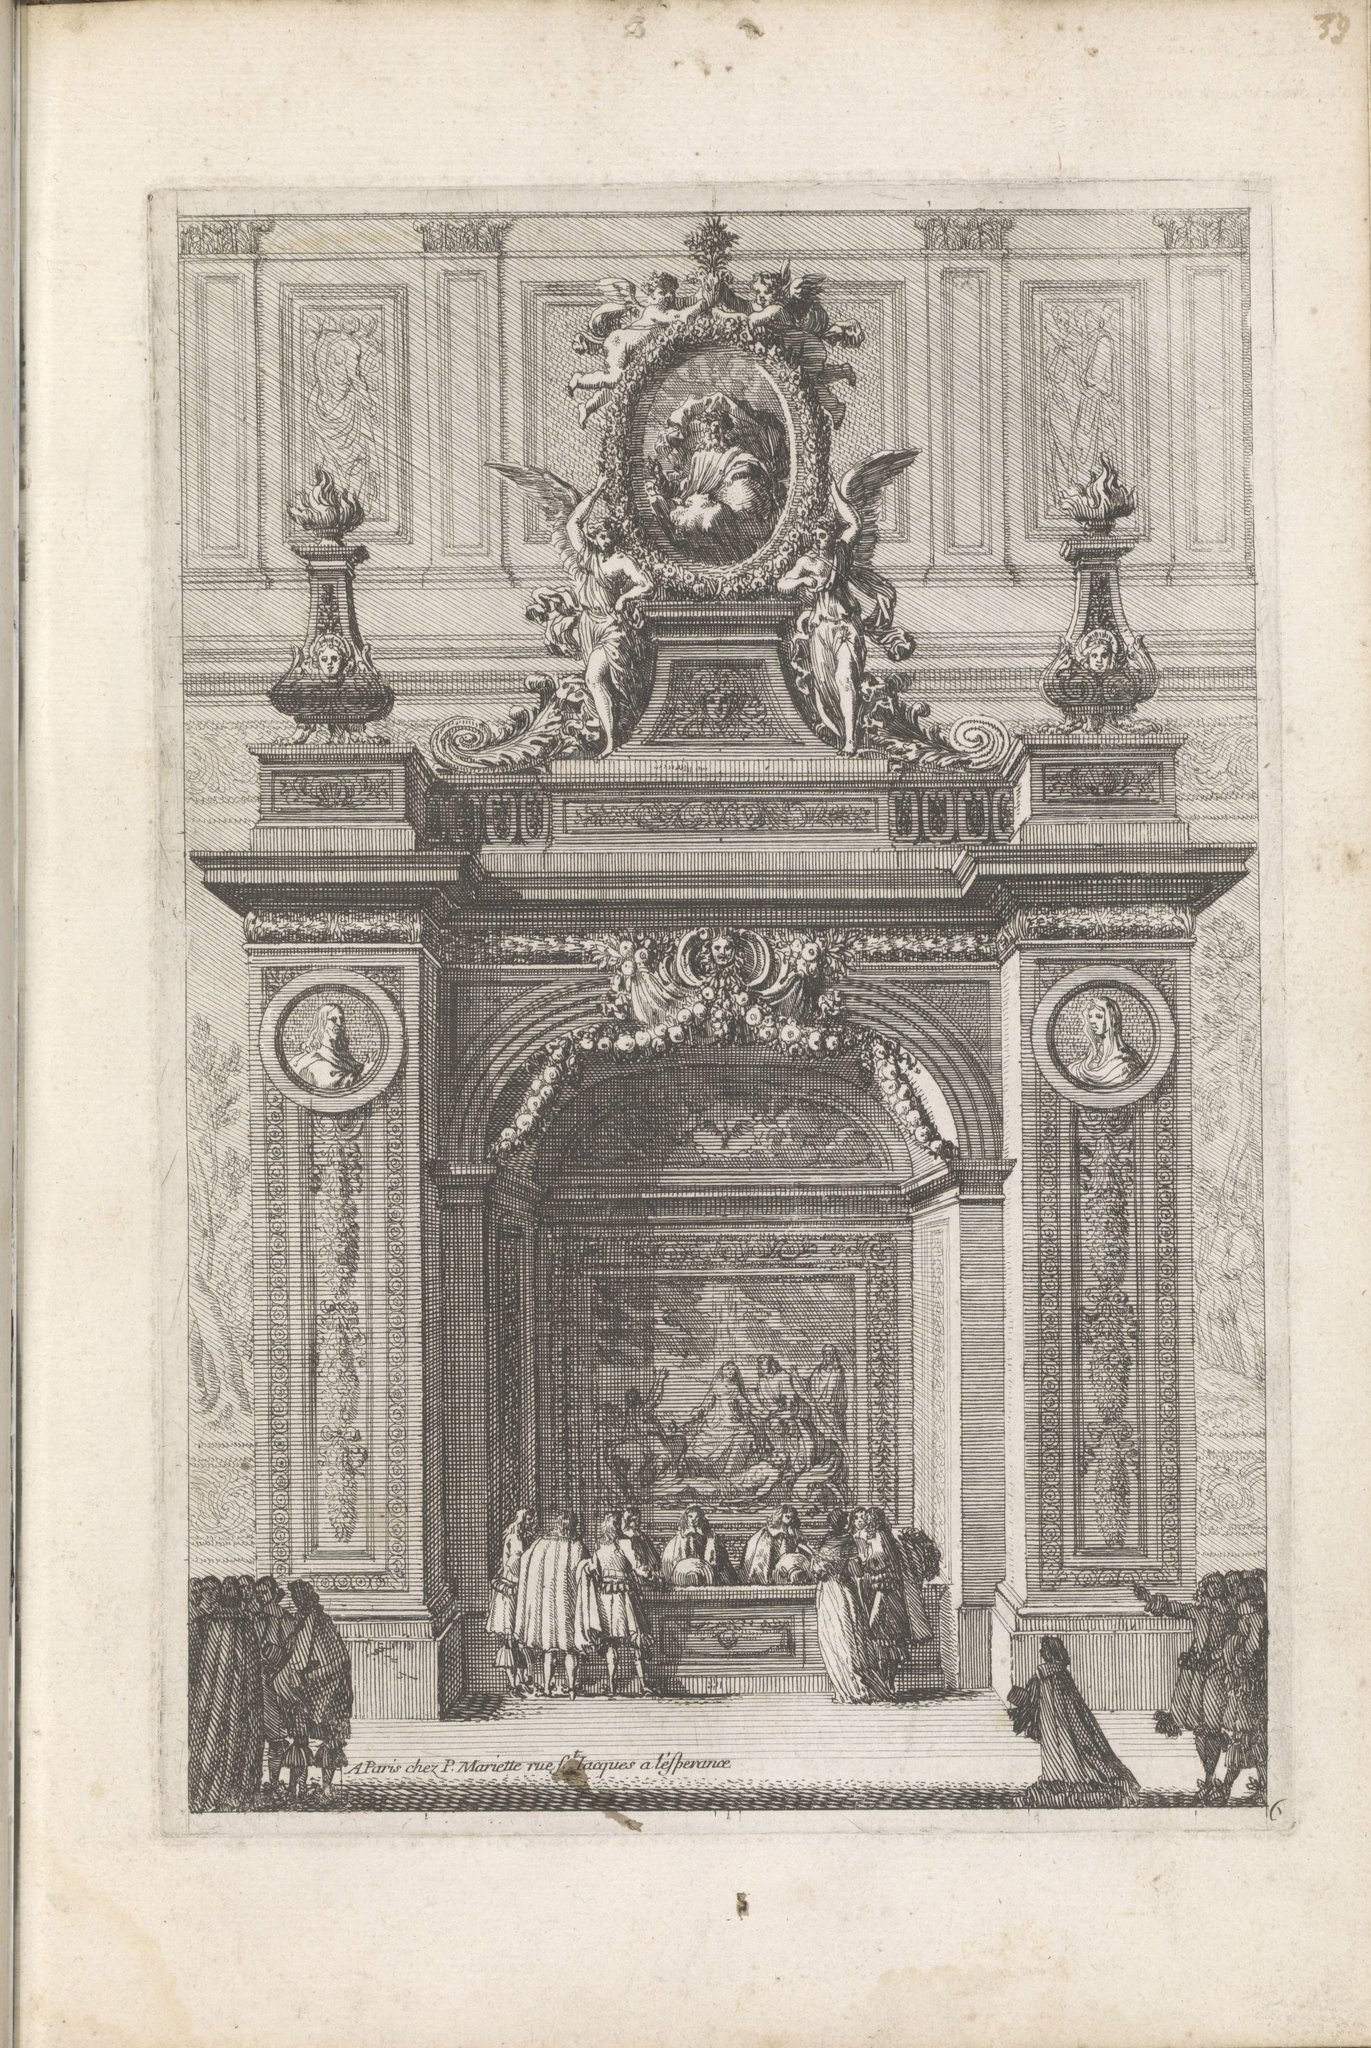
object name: ornament print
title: Koorbank in een kapel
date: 1657-1665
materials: paper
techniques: etching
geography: paris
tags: ornaments ~ art, seats of the clergy, choir-stalls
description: Koorbank in een kapel. Rondom figuren. Aan weerskanten staan pijlers bekroond met vlammende balusters. Prent maakt deel uit van een album.